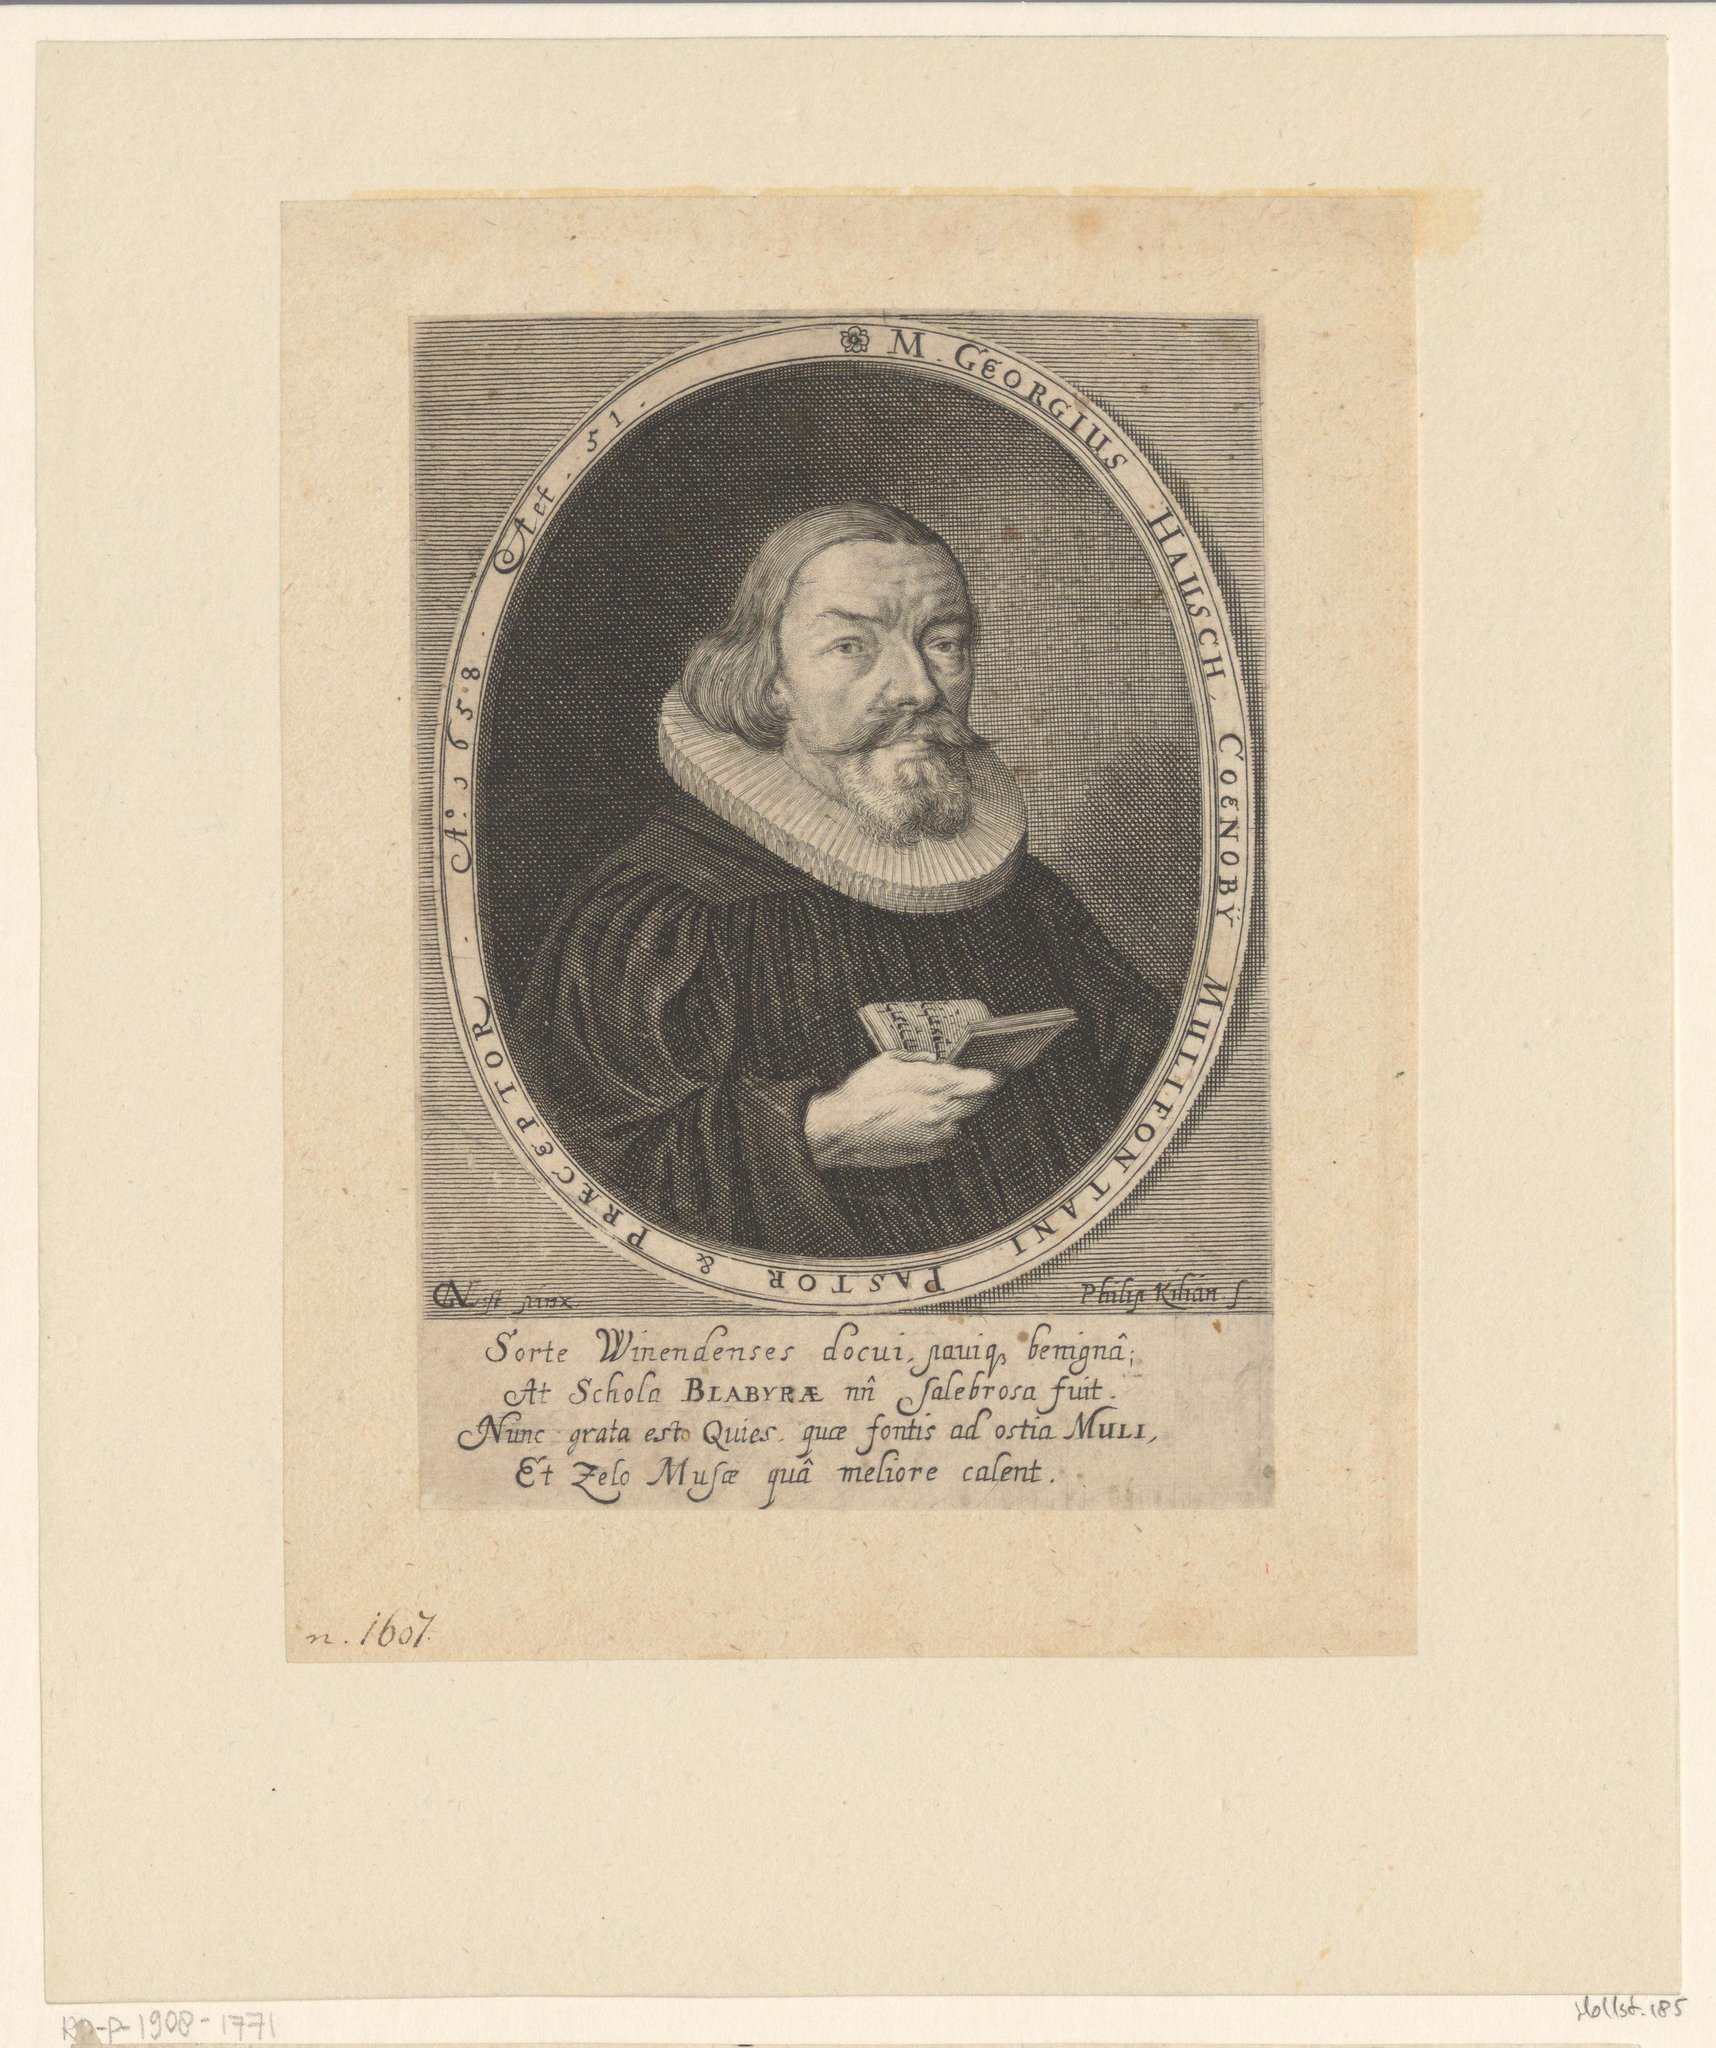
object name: print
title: Portret van Georg Hausch op 51-jarige leeftijd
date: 1658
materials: paper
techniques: engraving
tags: theologian, historical persons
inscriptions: collector's mark: Lugt 2228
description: Tekst in het Latijn in de omlijsting en in de ondermarge, tekst in het Hebreeuws in het boek.